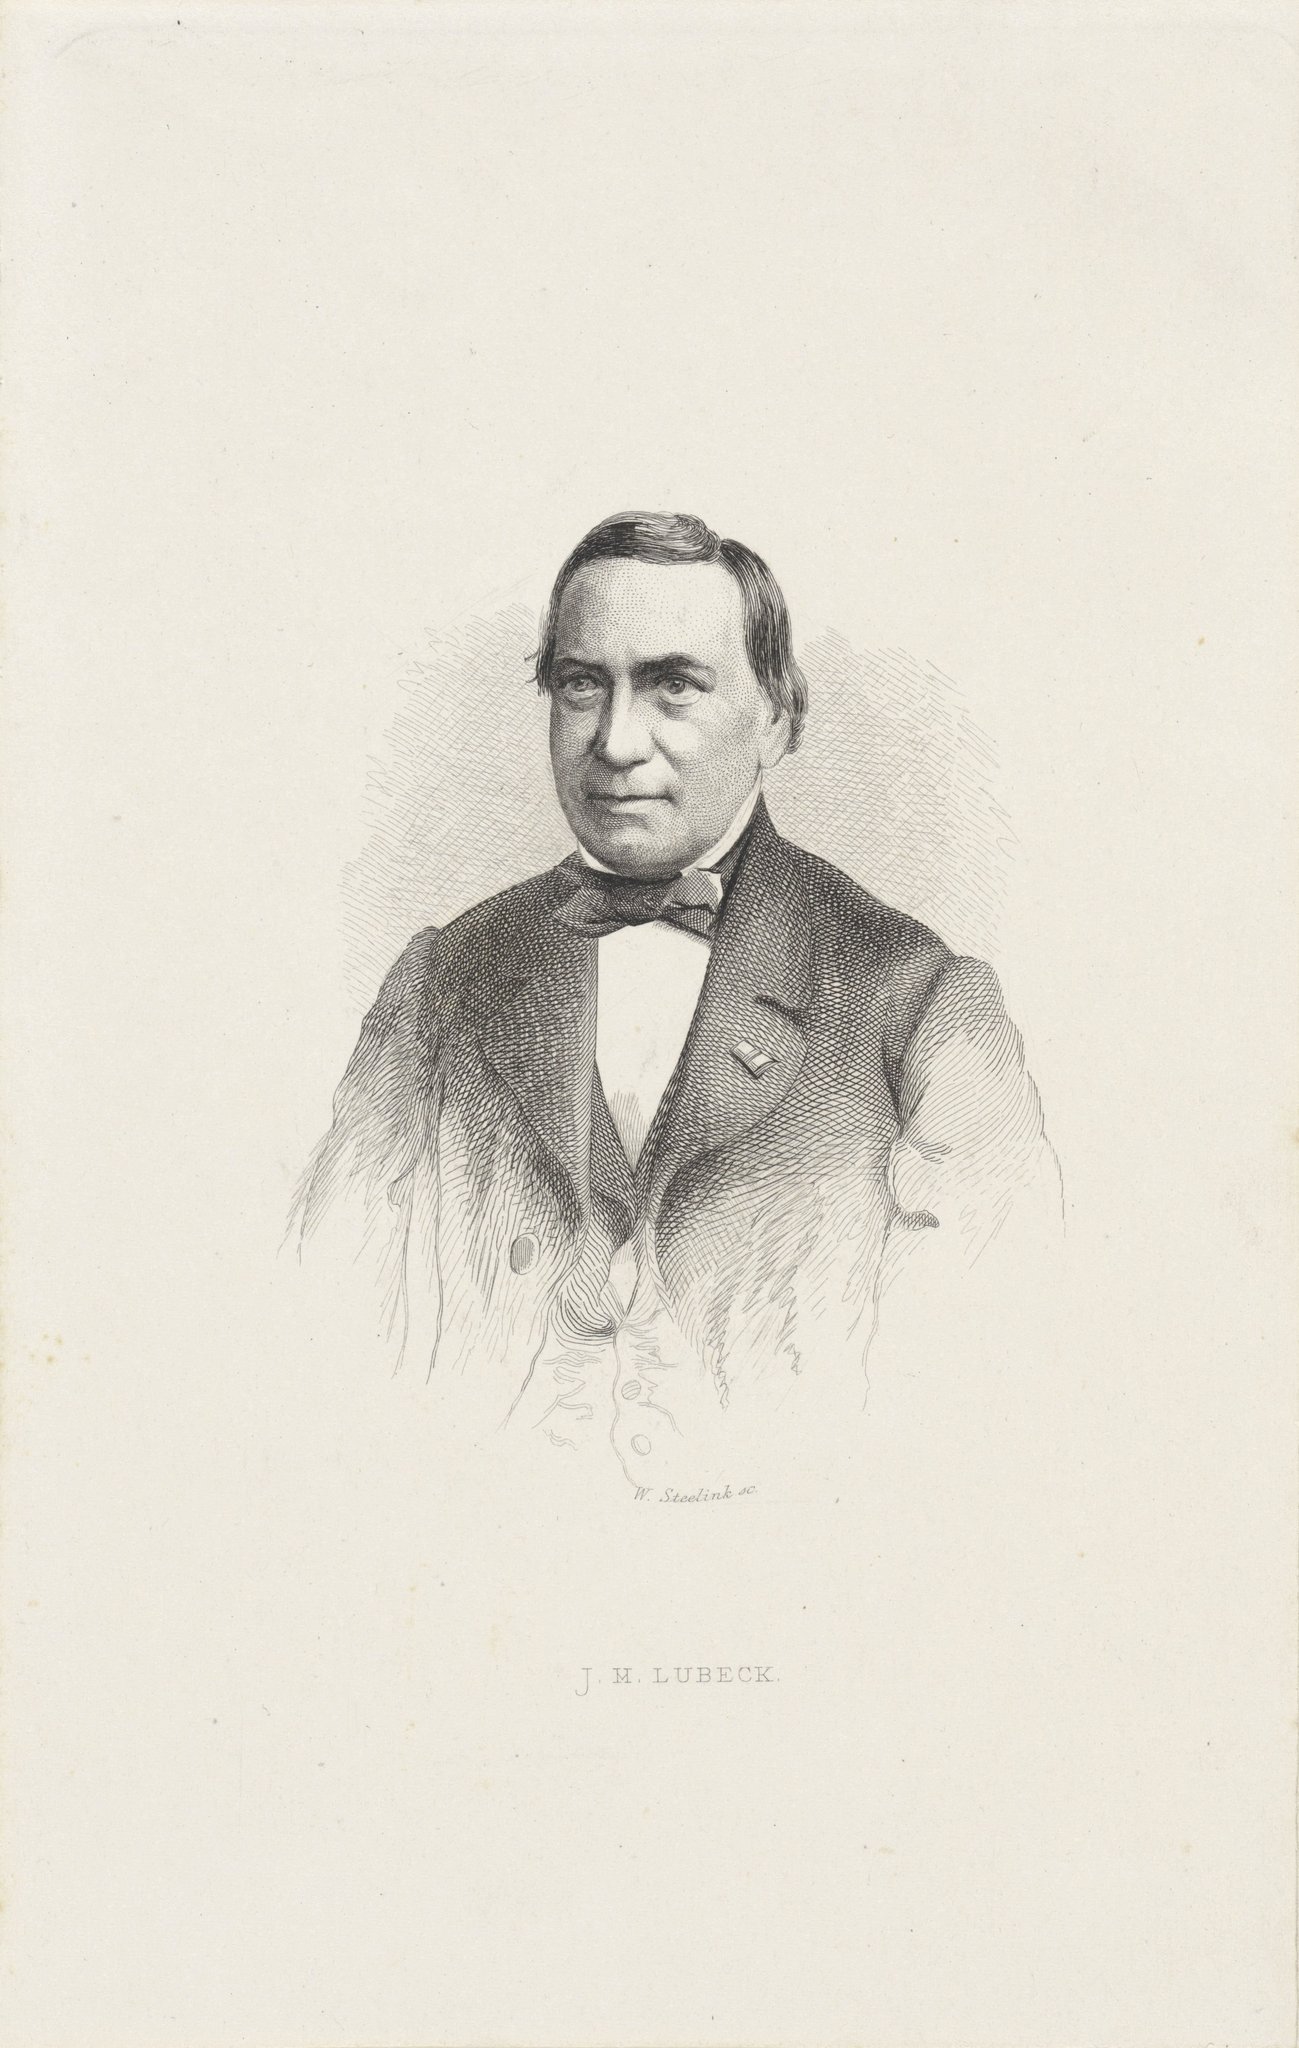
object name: print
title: Portret van Johann Heinrich Lubeck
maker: willem steelink (i)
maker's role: draughtsman, print maker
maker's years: 1826-1913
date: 1836-1911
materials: paper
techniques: engraving, etching, roulette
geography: amsterdam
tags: the hague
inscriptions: collector's mark: Lugt 2228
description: Portret van Johann Heinrich Lubeck, concertmeester te Amsterdam.